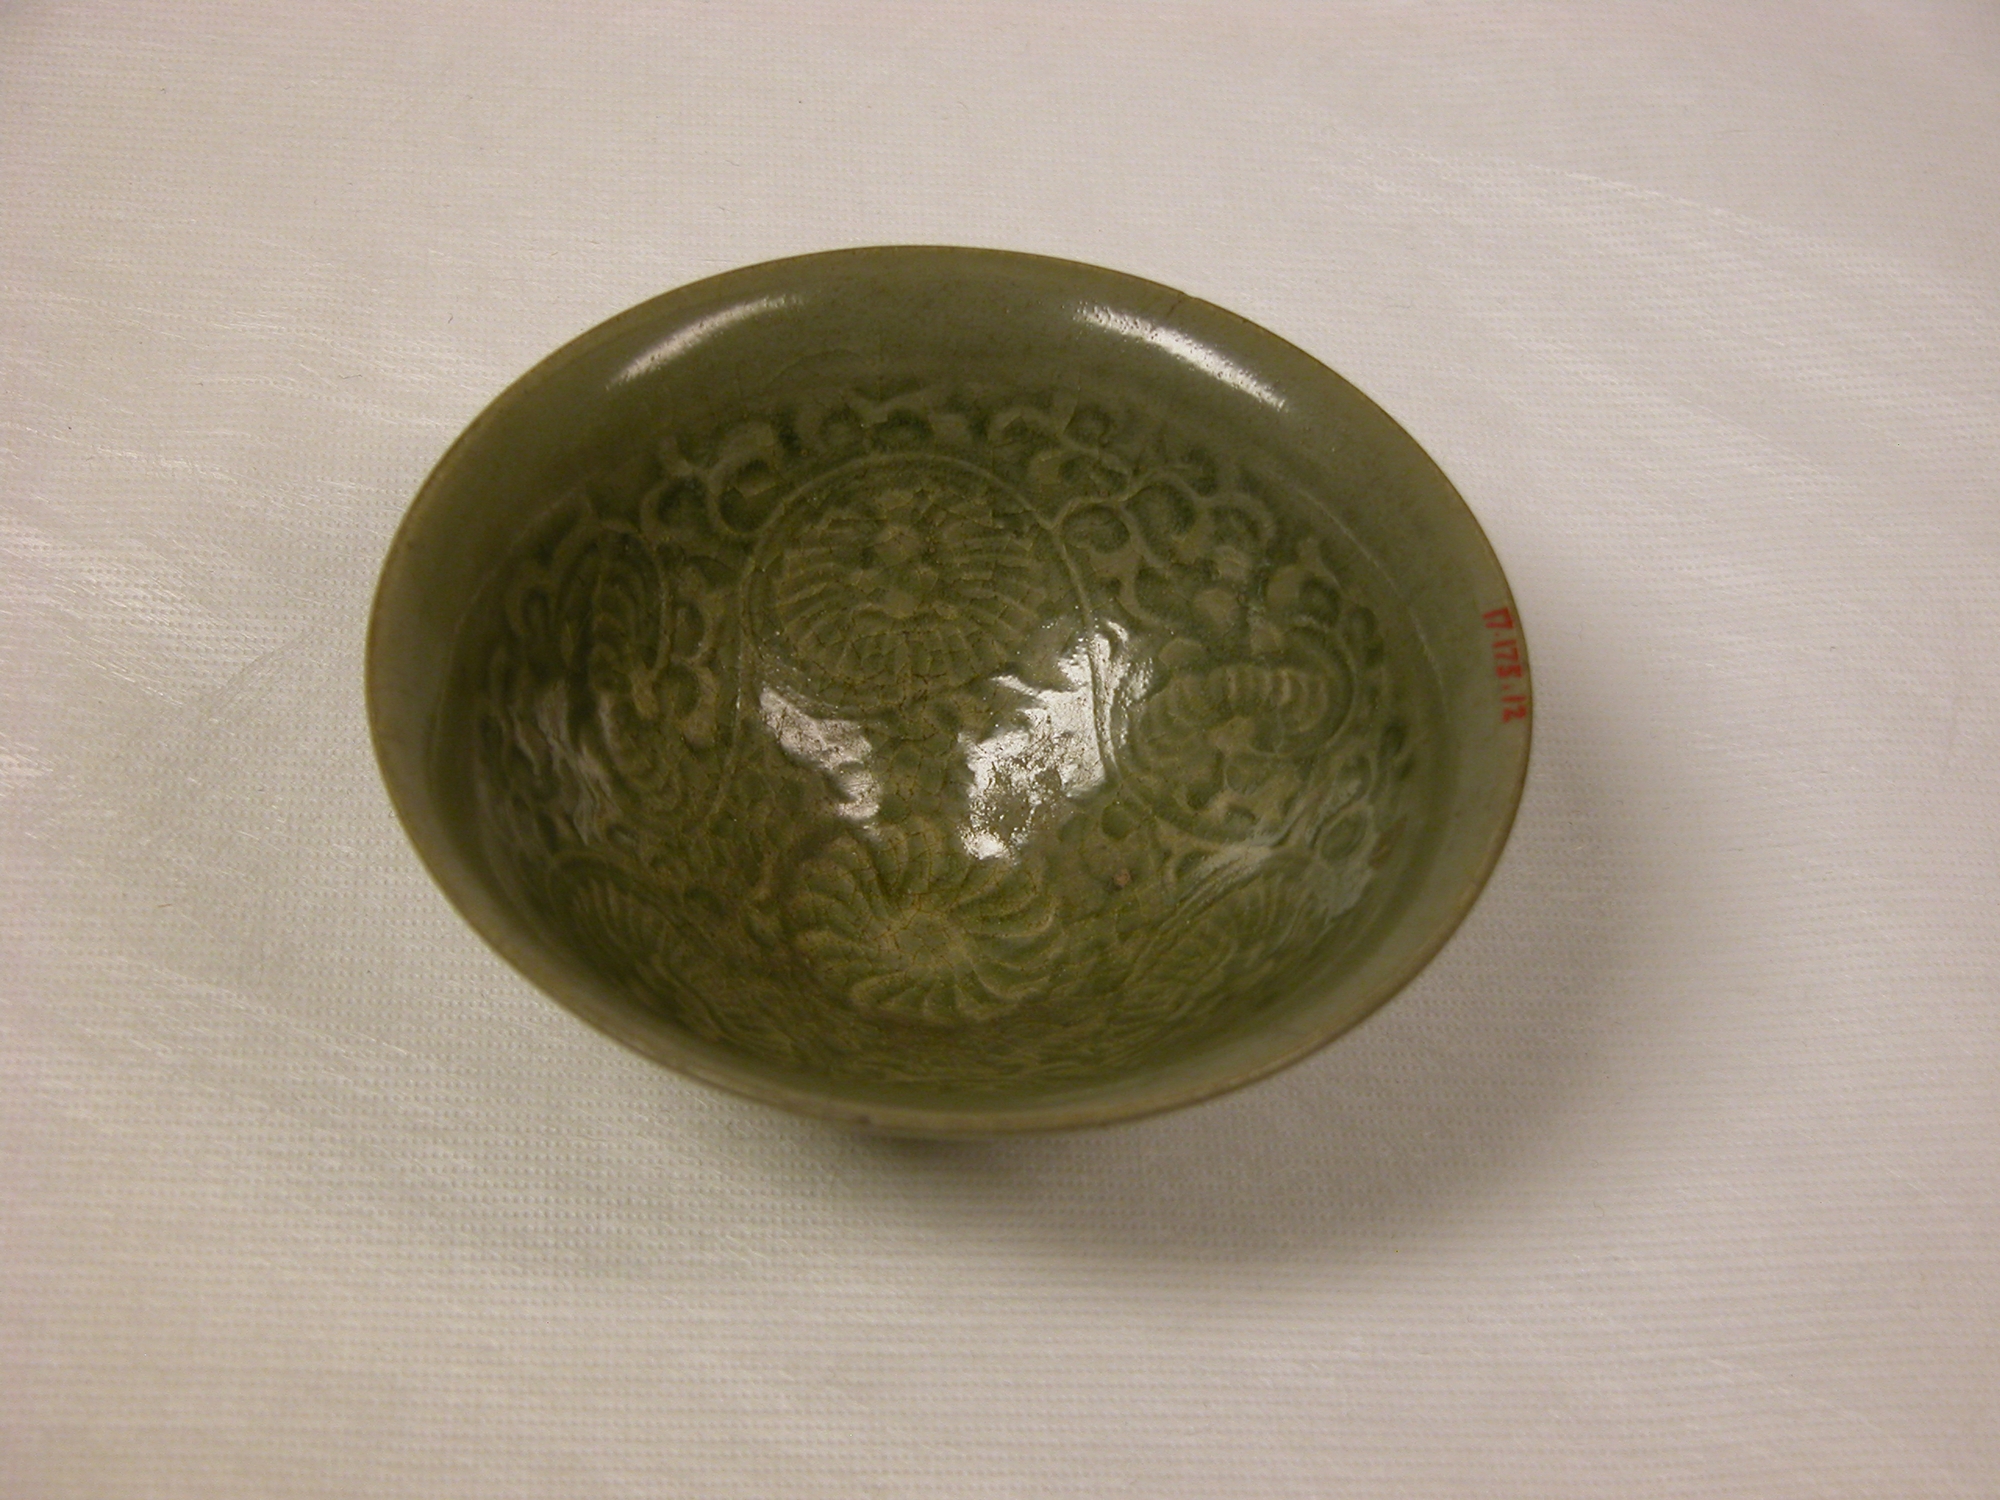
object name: bowl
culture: chinese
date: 960-1279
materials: pottery